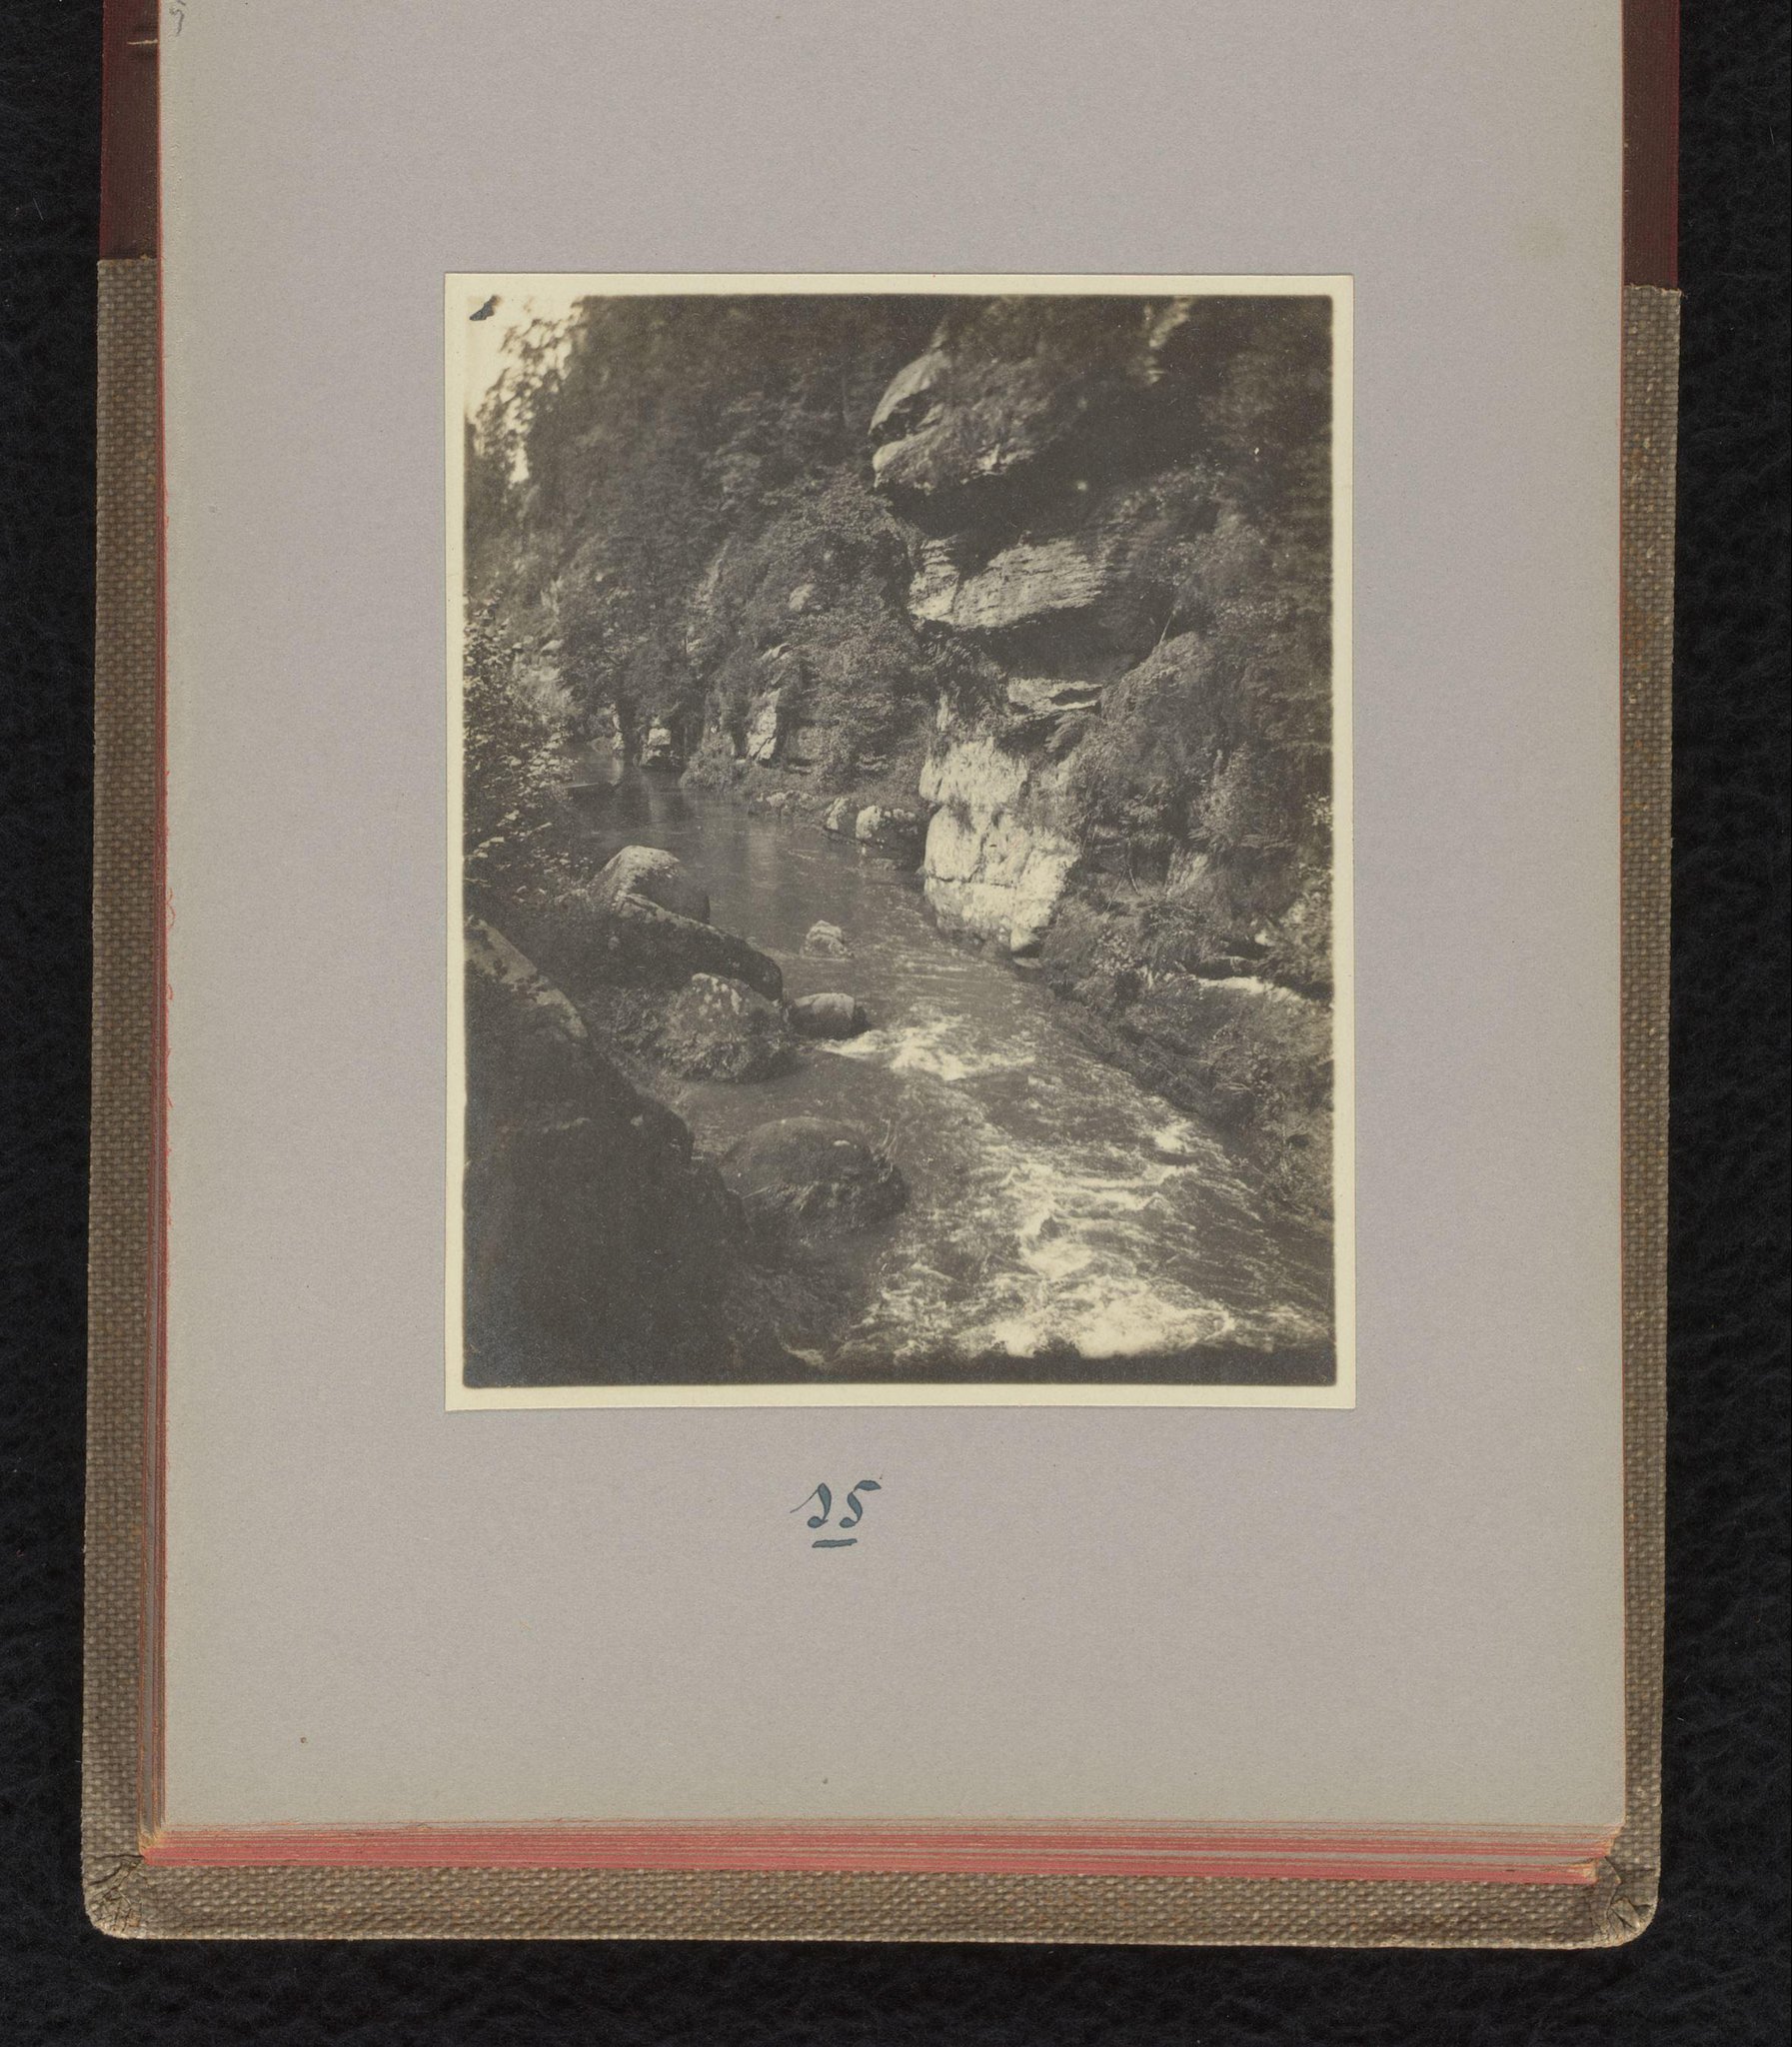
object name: photograph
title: Wilde Klamm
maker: johan herman kessler (jan)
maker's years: 1892-1978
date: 1910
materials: paper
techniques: gelatin silver print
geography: bohemia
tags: river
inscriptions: number: ‘15’